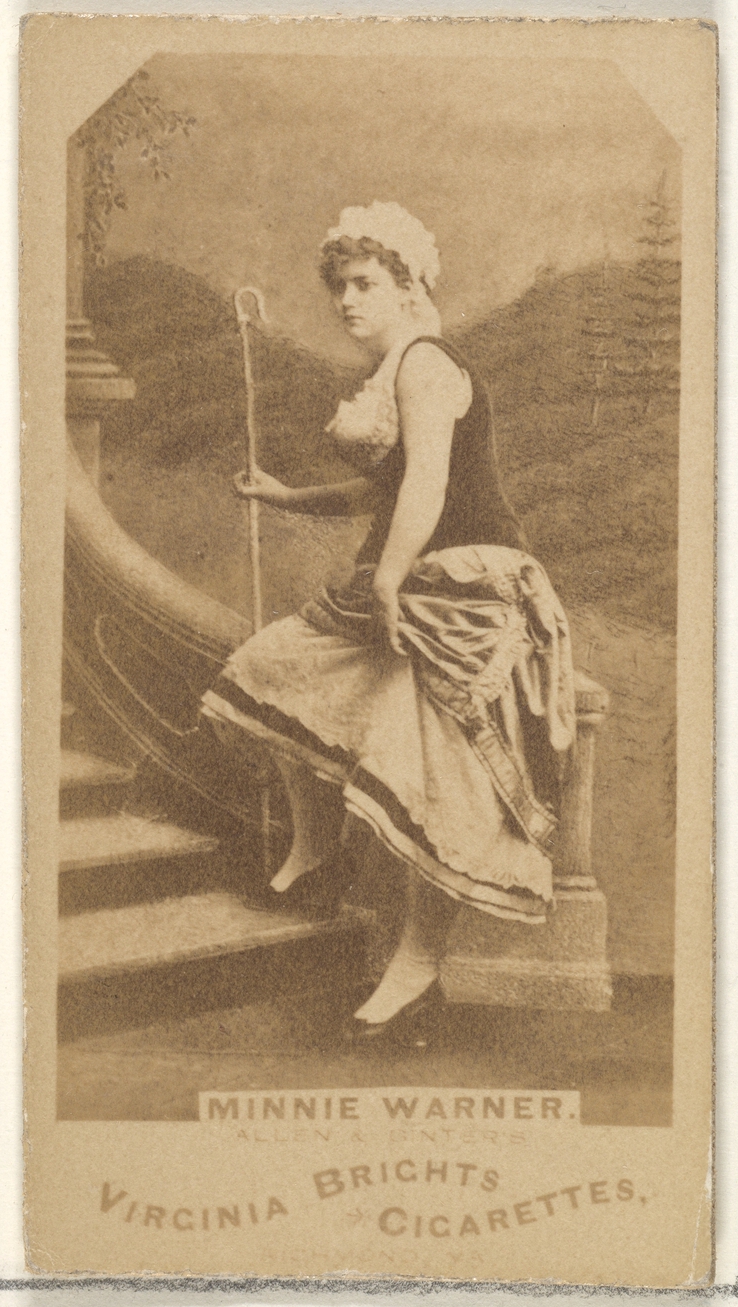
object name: photograph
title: Minnie Warner, from the Actors and Actresses series (N45, Type 1) for Virginia Brights Cigarettes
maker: allen & ginter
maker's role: publisher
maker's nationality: american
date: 1888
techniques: albumen silver print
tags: portraits,women,actresses